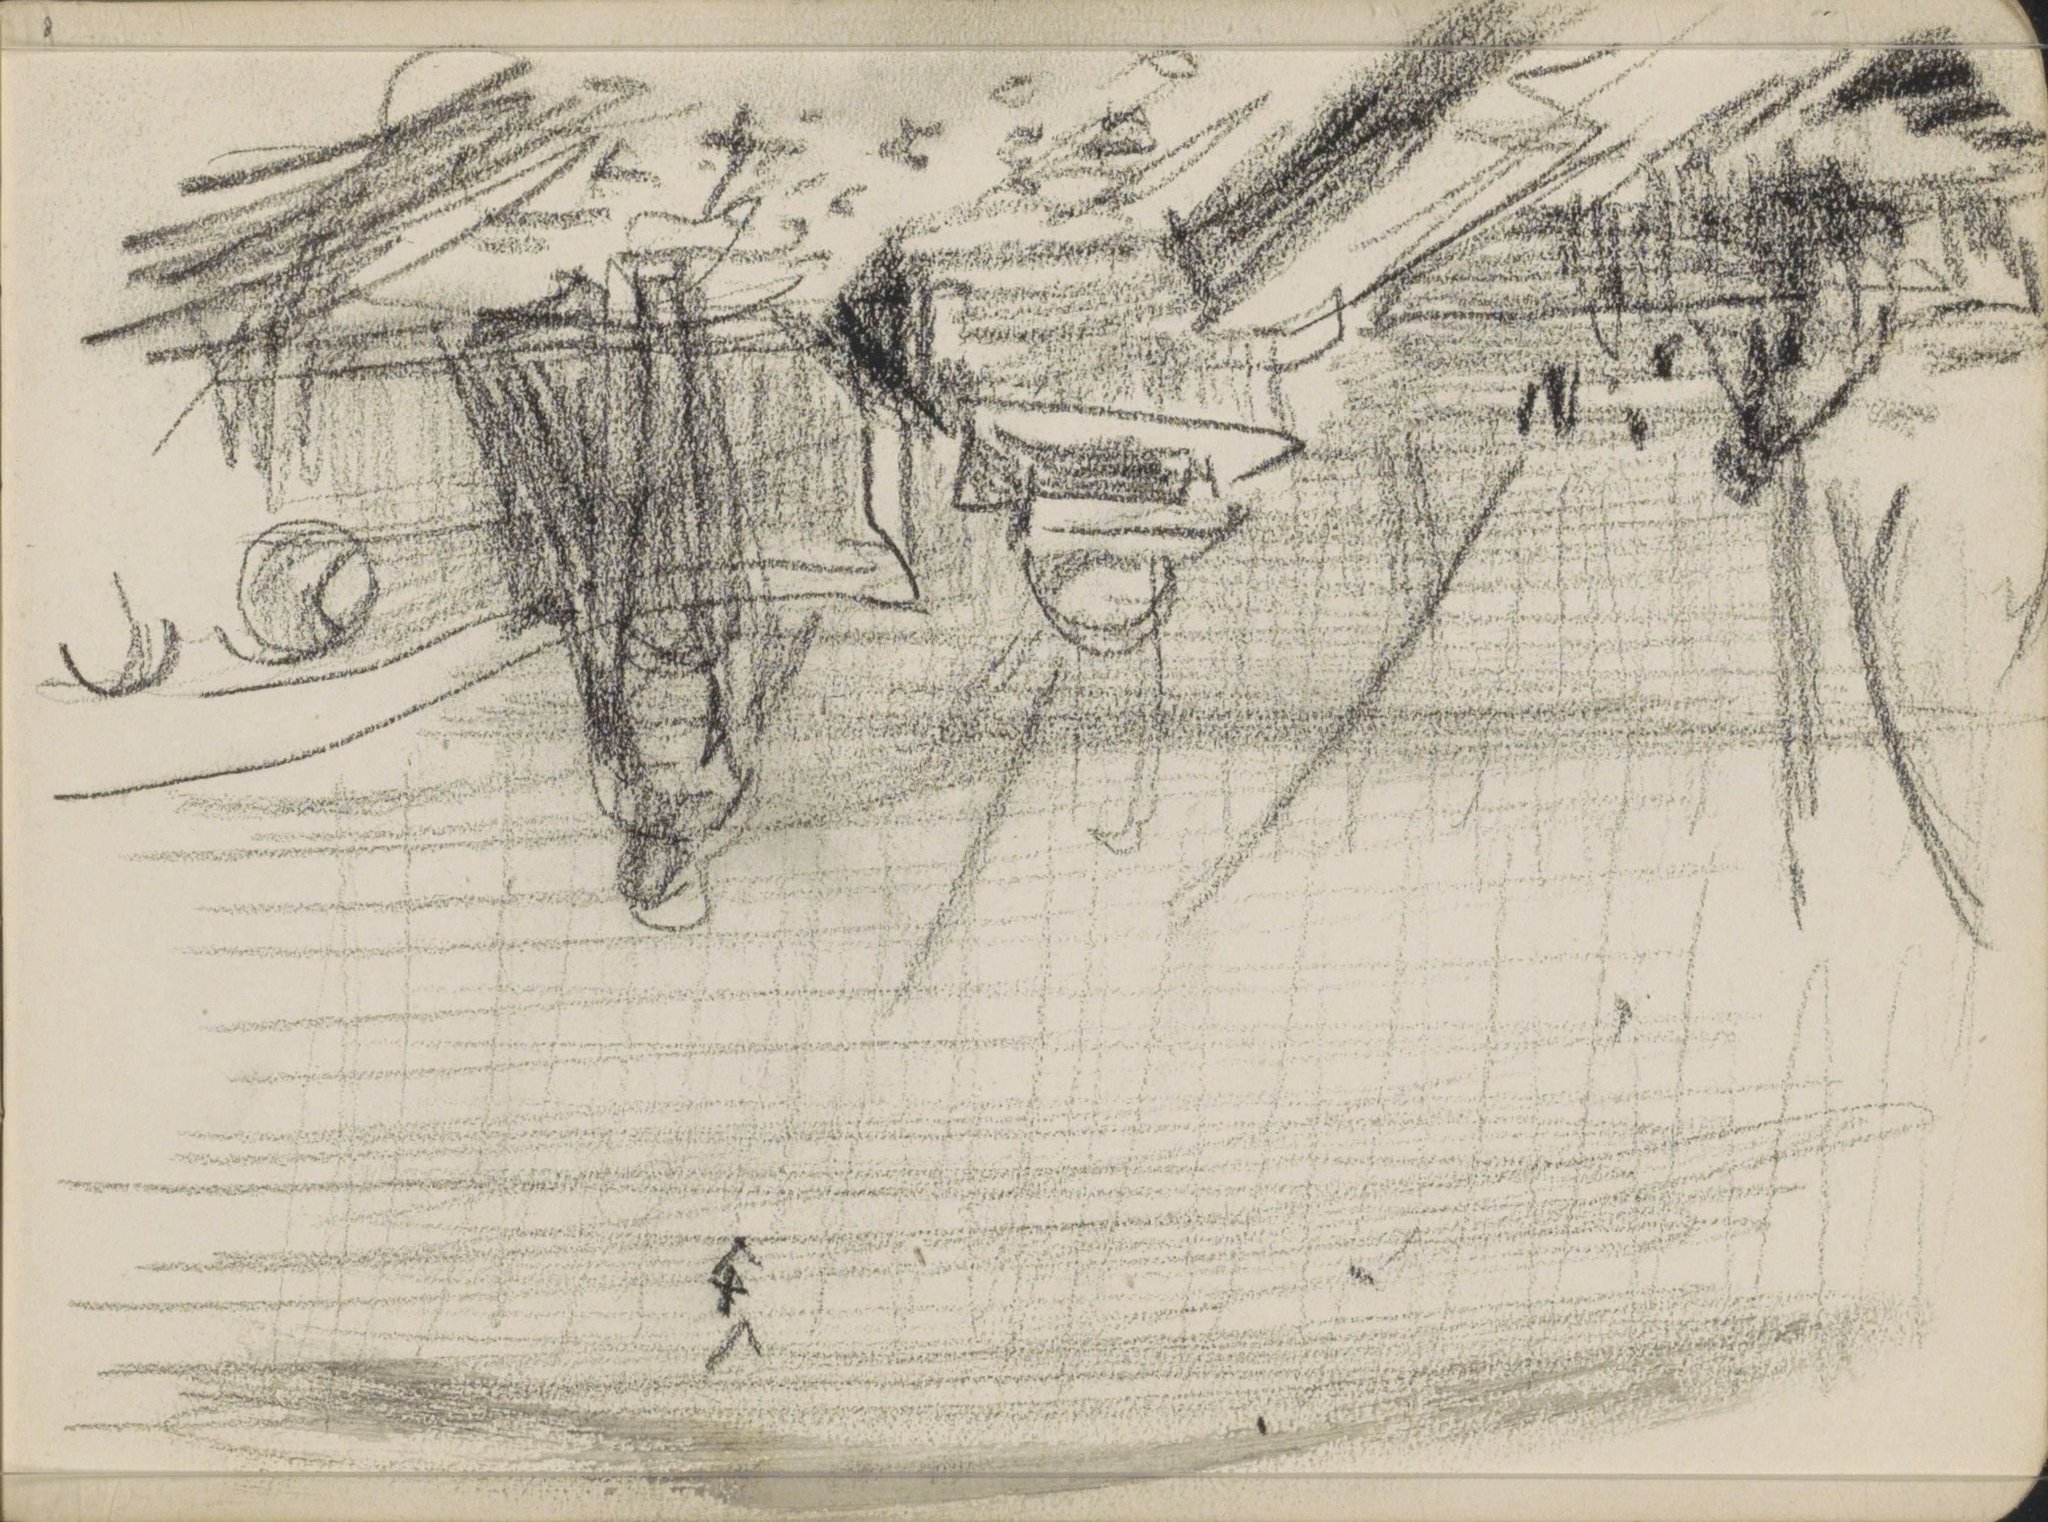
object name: sketchbook leaf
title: Figuur op een balkon, uitkijkend over de Nijl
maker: marius bauer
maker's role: draughtsman, print maker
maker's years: 1867-1932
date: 1919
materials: chalk, paper, watercolor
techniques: brush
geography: luxor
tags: standing figure, river, balcony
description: Pagina 8 uit een schetsboek met 28 bladen.